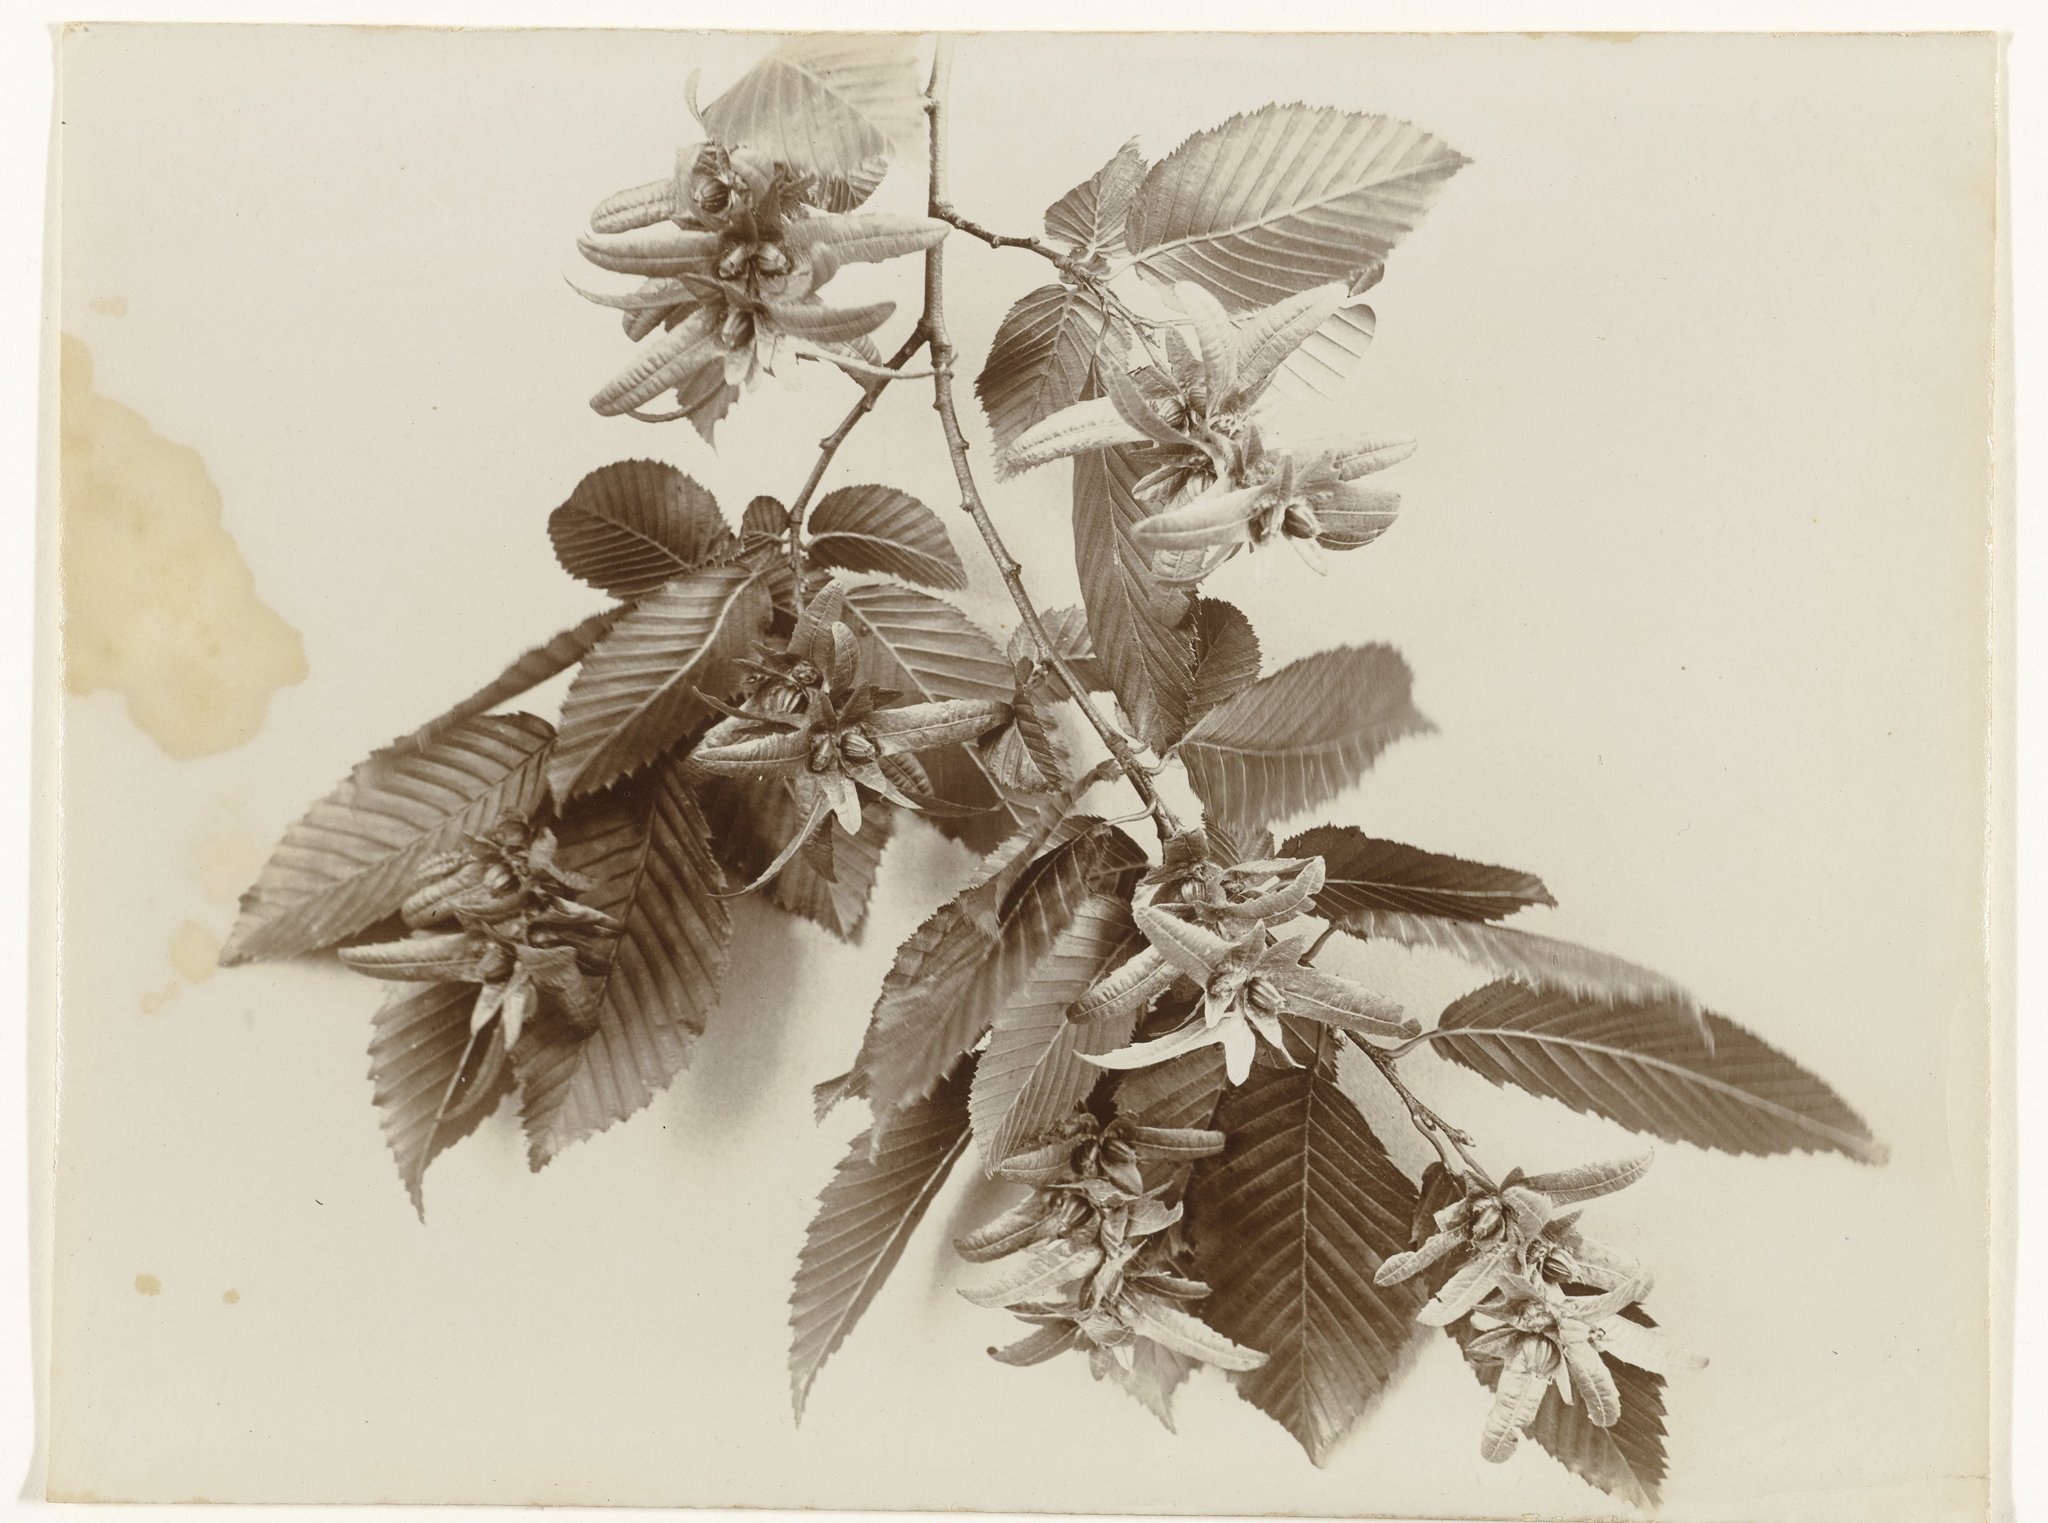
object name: photograph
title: bovenzyde, Haagbeuk, vruchtdragende Tak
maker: richard tepe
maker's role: fotograaf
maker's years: 1864-1952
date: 1900-1930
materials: photographic support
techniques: gelatin silver print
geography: netherlands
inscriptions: signature: ‘foto / R. Tepe’, annotation: ‘bovenzyde / Haagbeuk, vruchtdragende Tak’